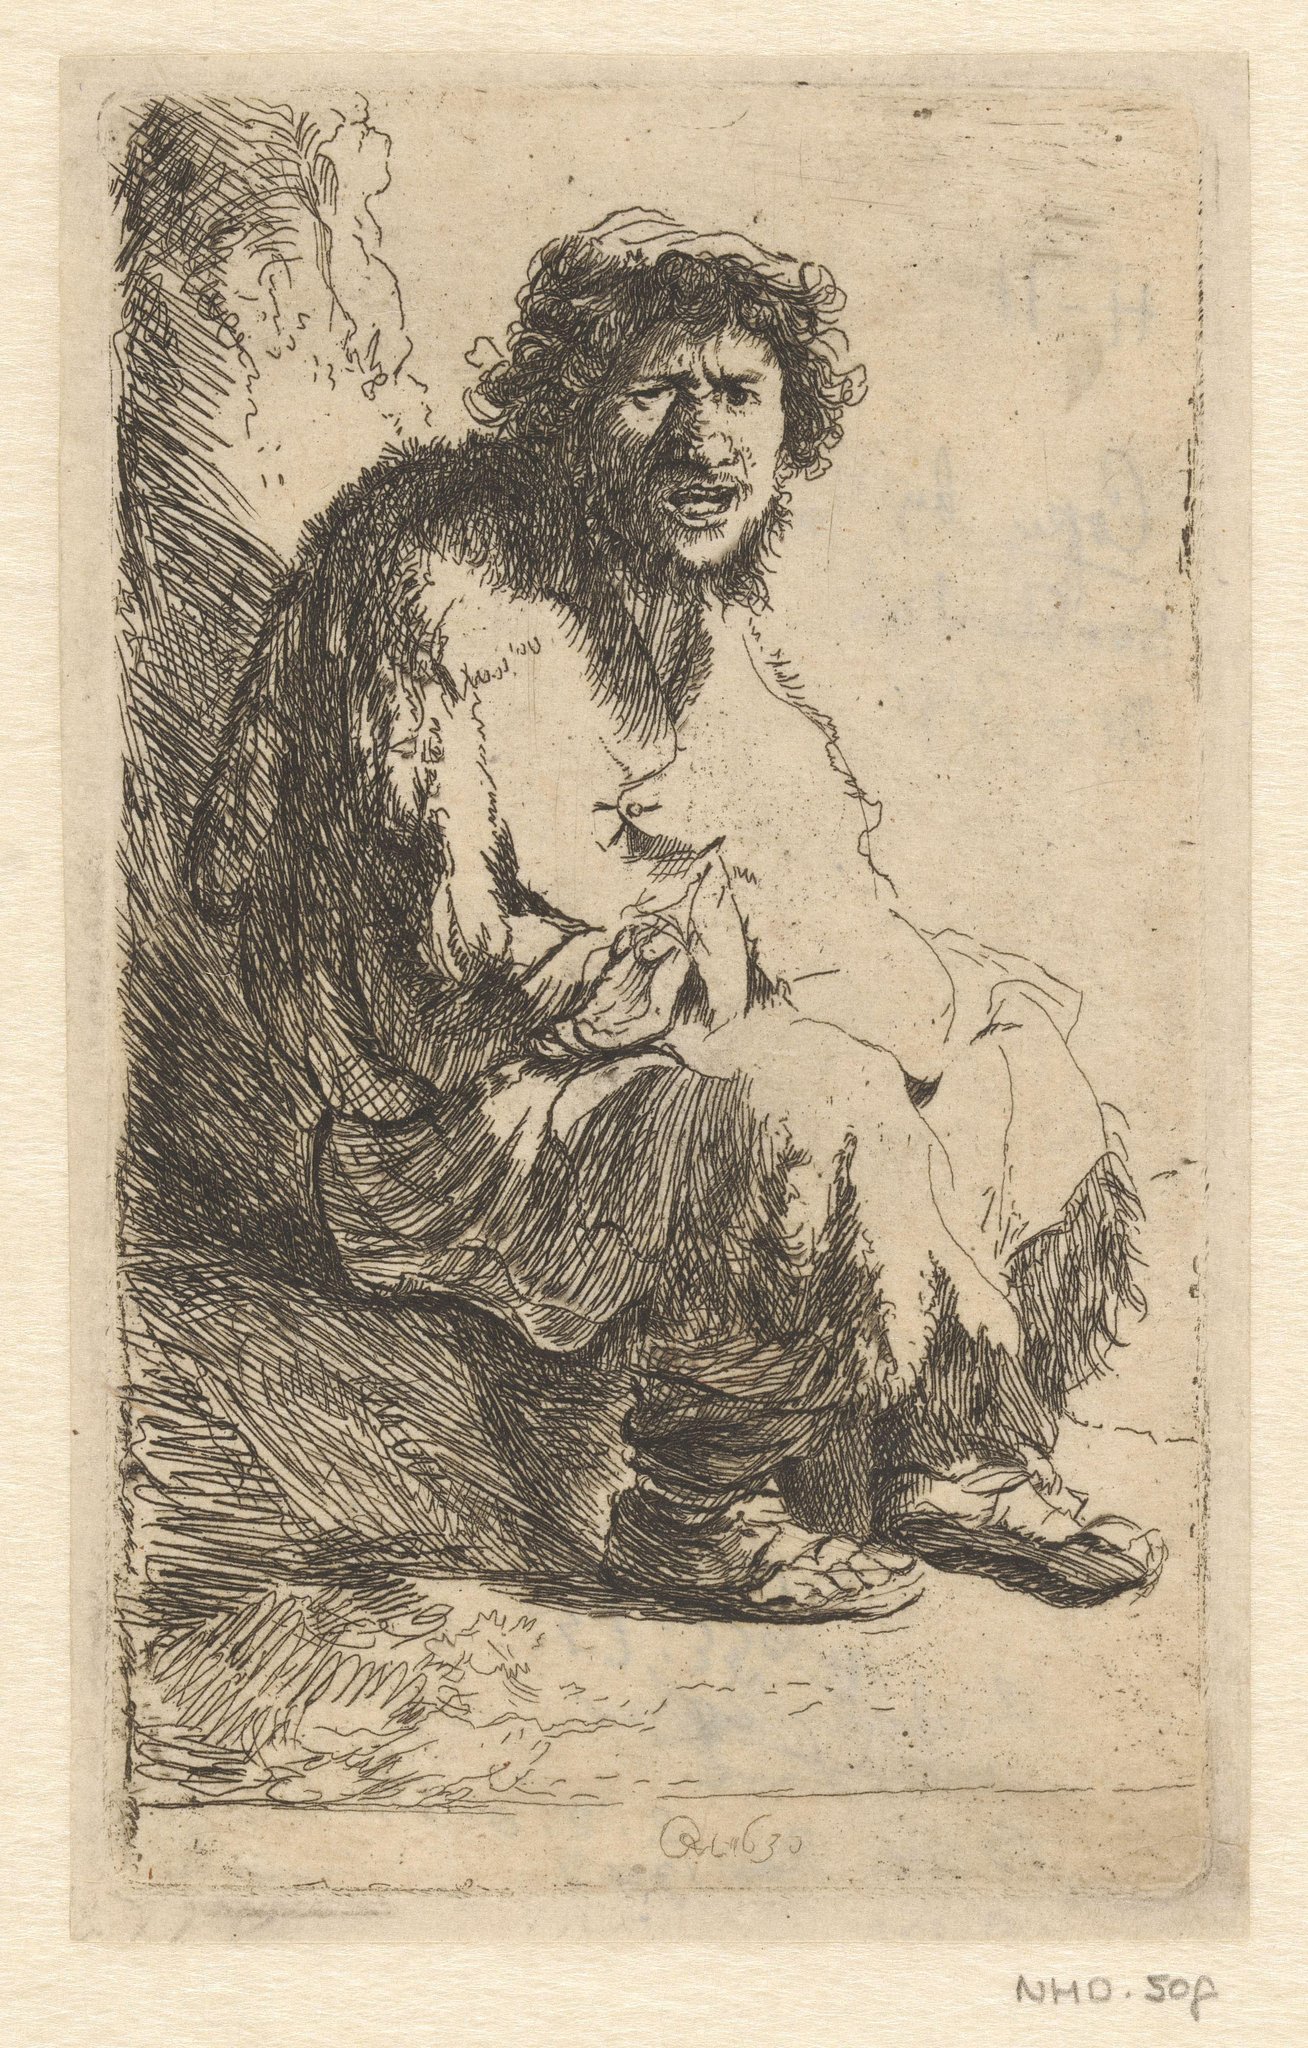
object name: print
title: Beggar seated on a bank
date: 1760-1781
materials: paper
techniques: etching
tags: beggar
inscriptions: collector's mark: Lugt 2228, collector's mark: Lugt 2760, collector's mark: Lugt 1318